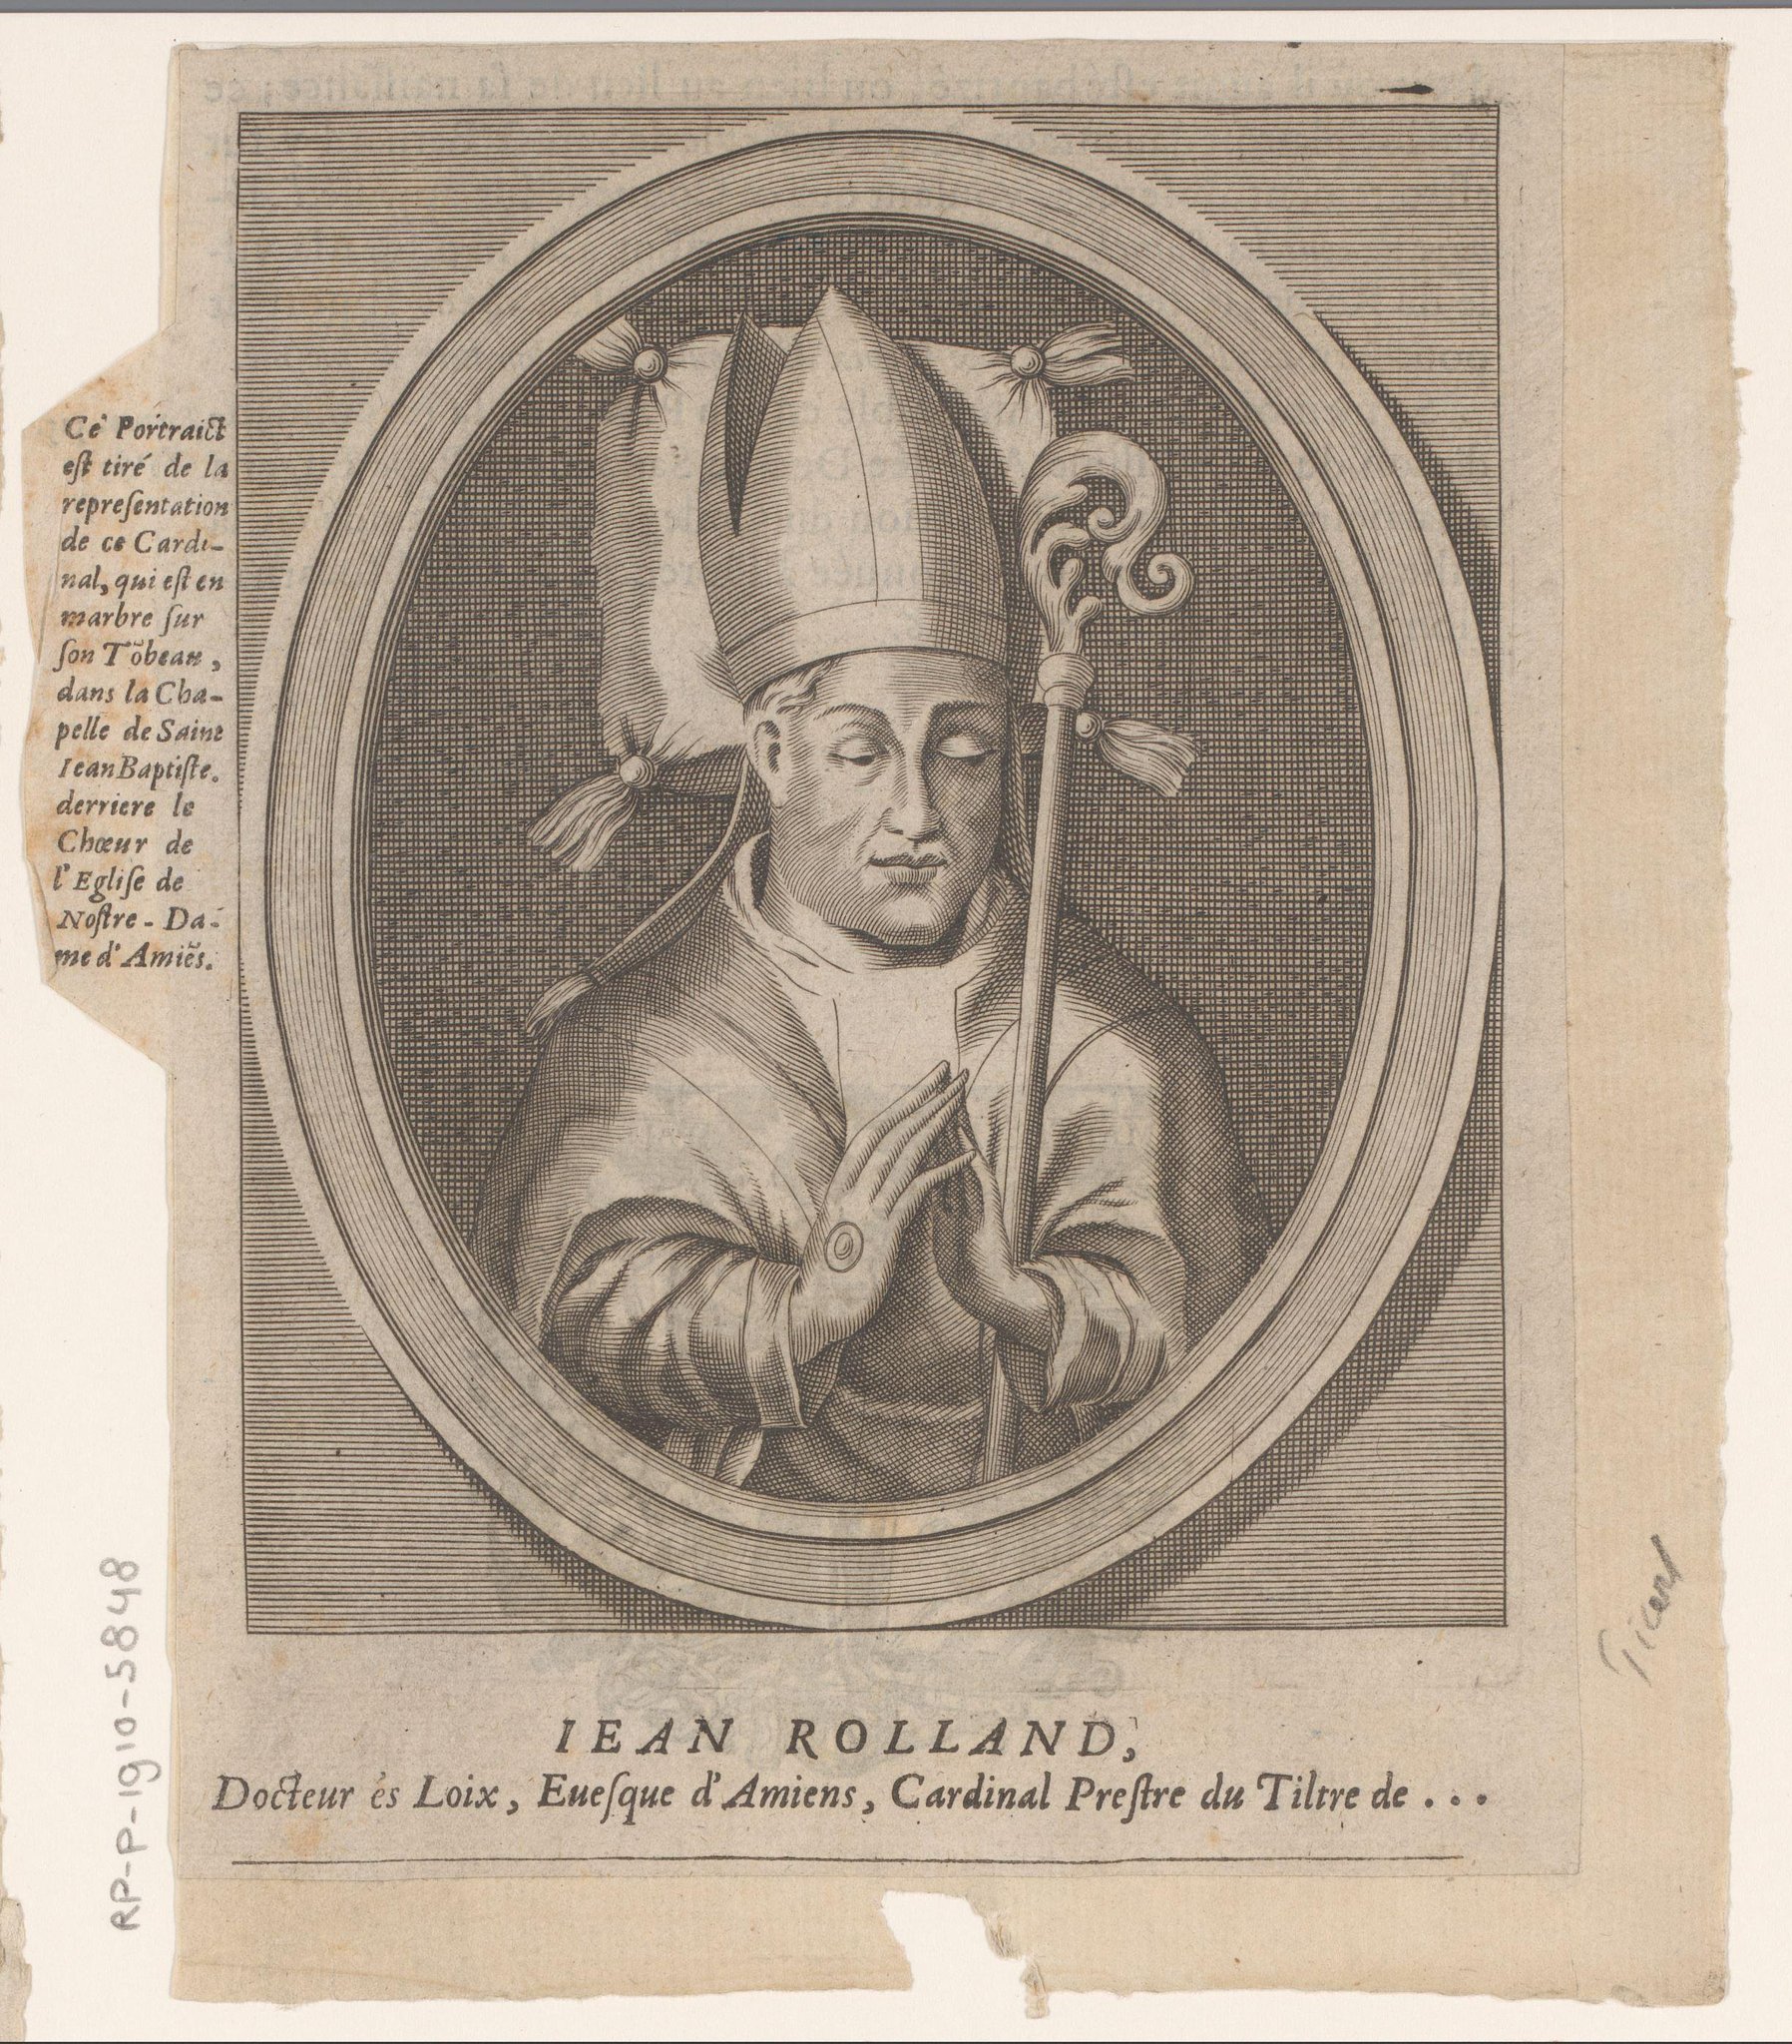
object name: print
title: Portret van Jean Rolland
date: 1660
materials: paper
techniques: engraving, etching, letterpress printing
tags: archbishop, bishop, etc. (roman catholic), historical persons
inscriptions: collector's mark: Lugt 2228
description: Prent uit: Du Chesne, François. Histoire de tous les cardinaux françois de naissance, ou qui ont esté promeus au cardinalat. Parijs: François Du Chesne, 1660.